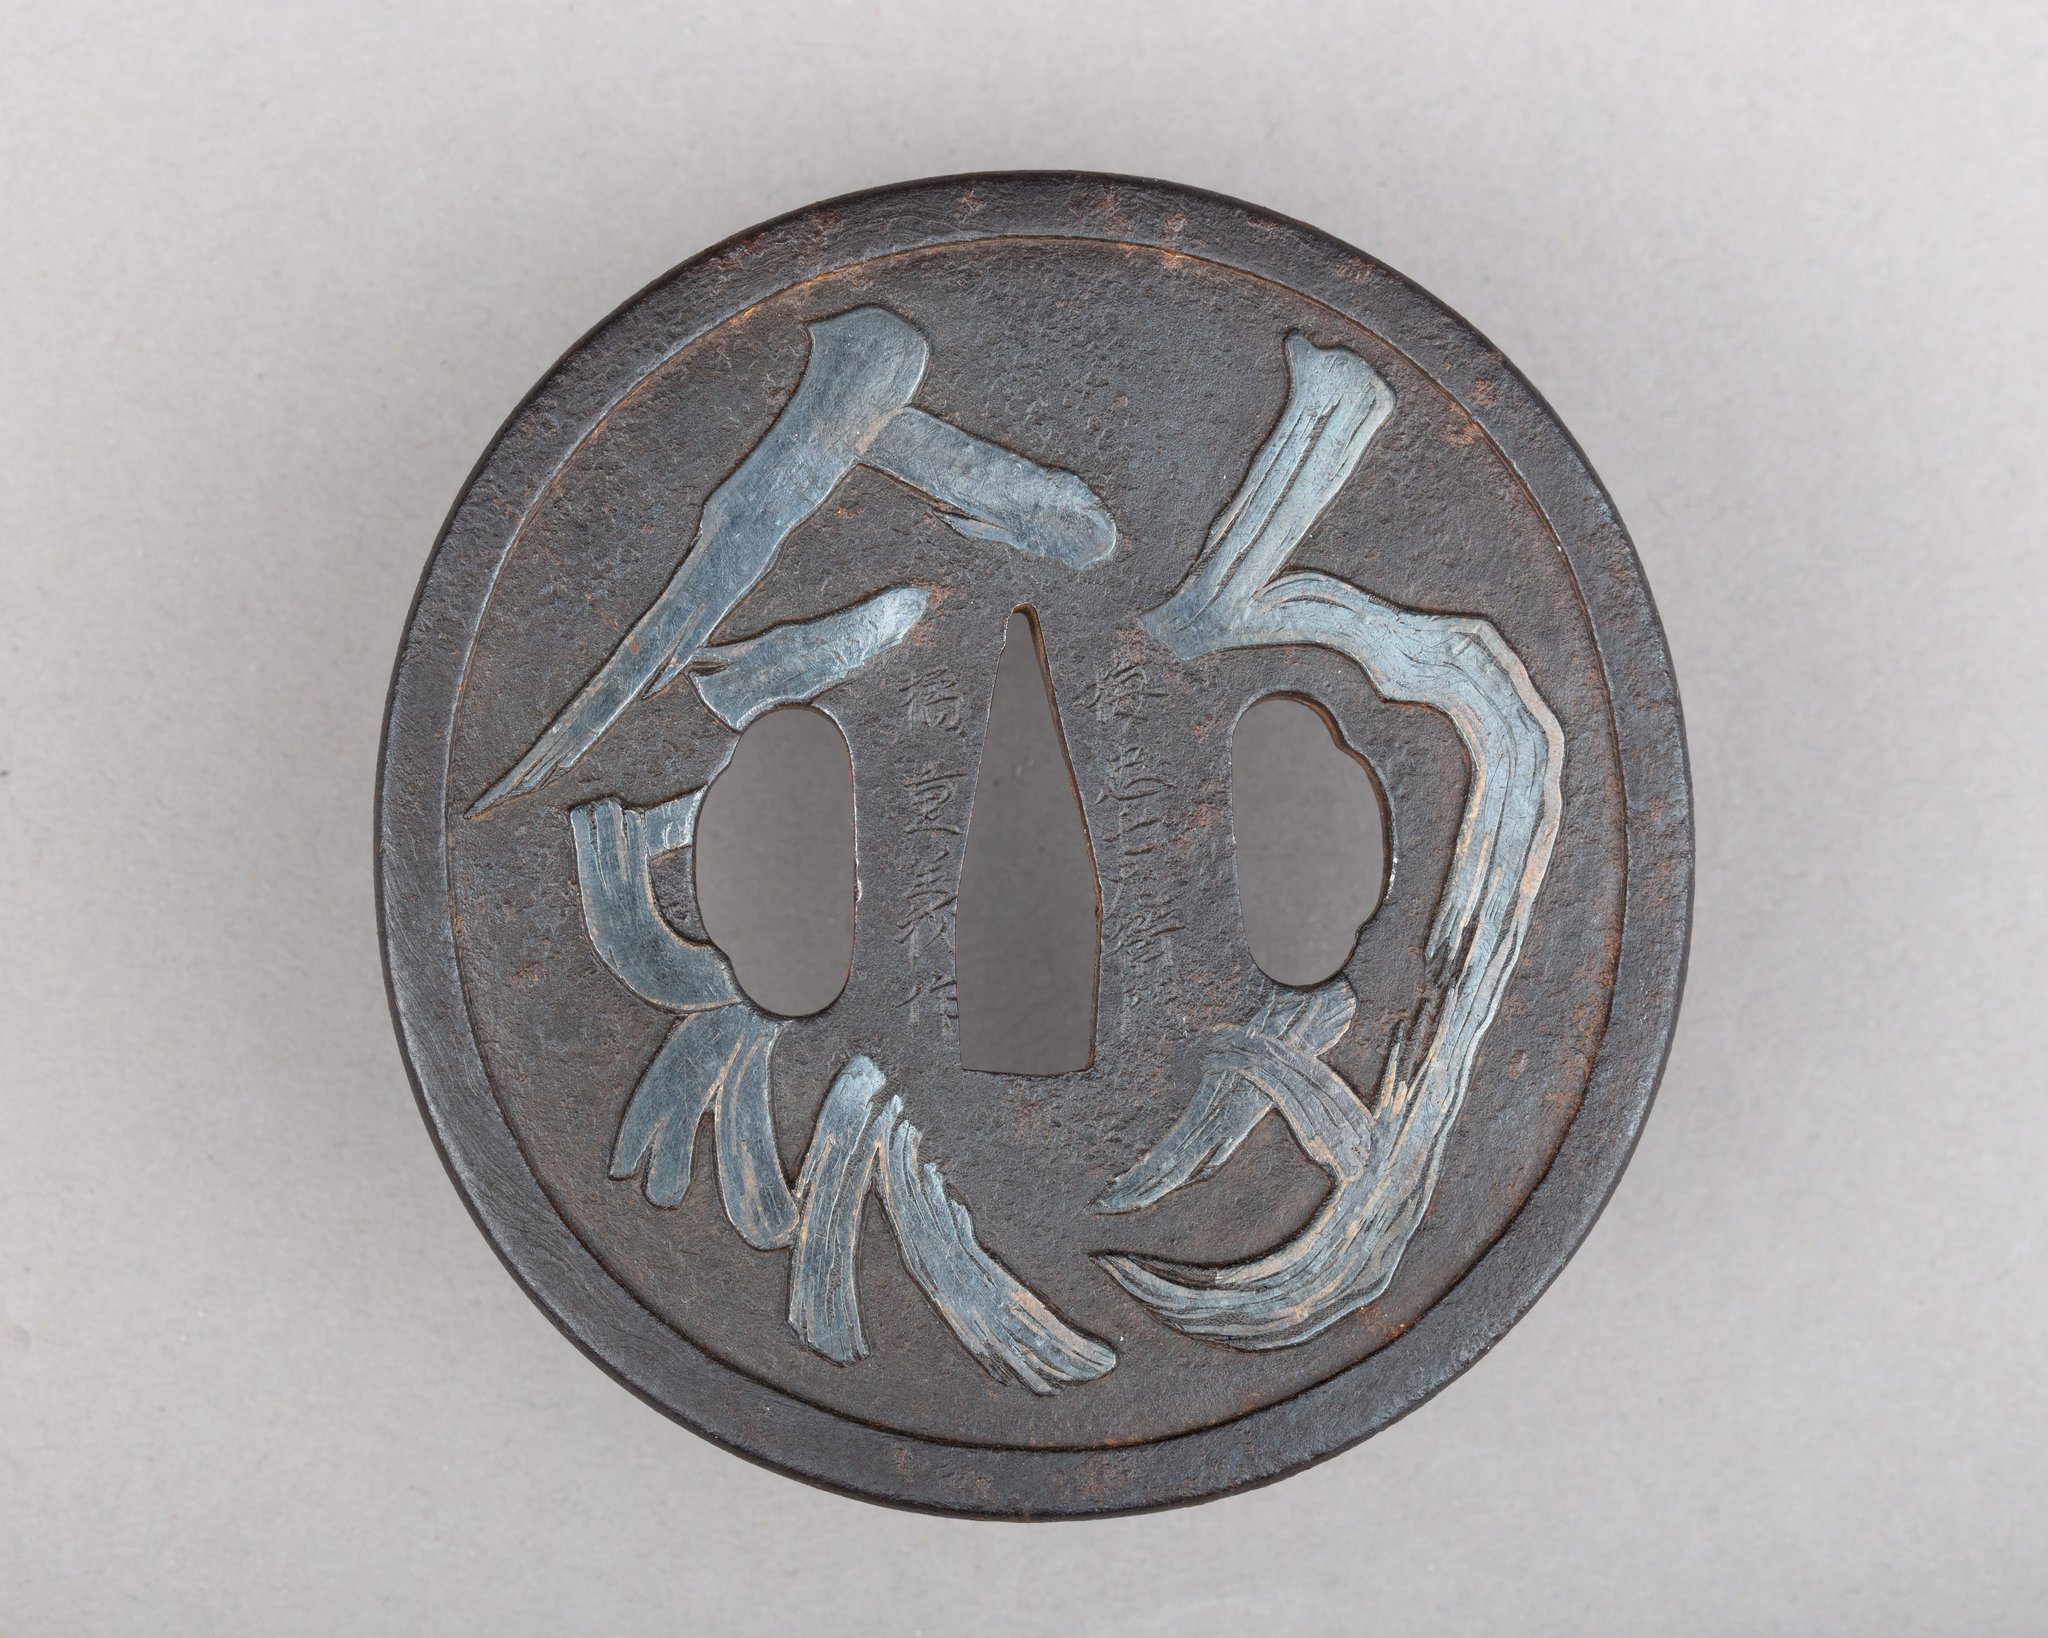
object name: sword guard tsuba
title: Sword Guard (Tsuba)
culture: japanese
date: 1650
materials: copper, gold, iron, silver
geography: japan